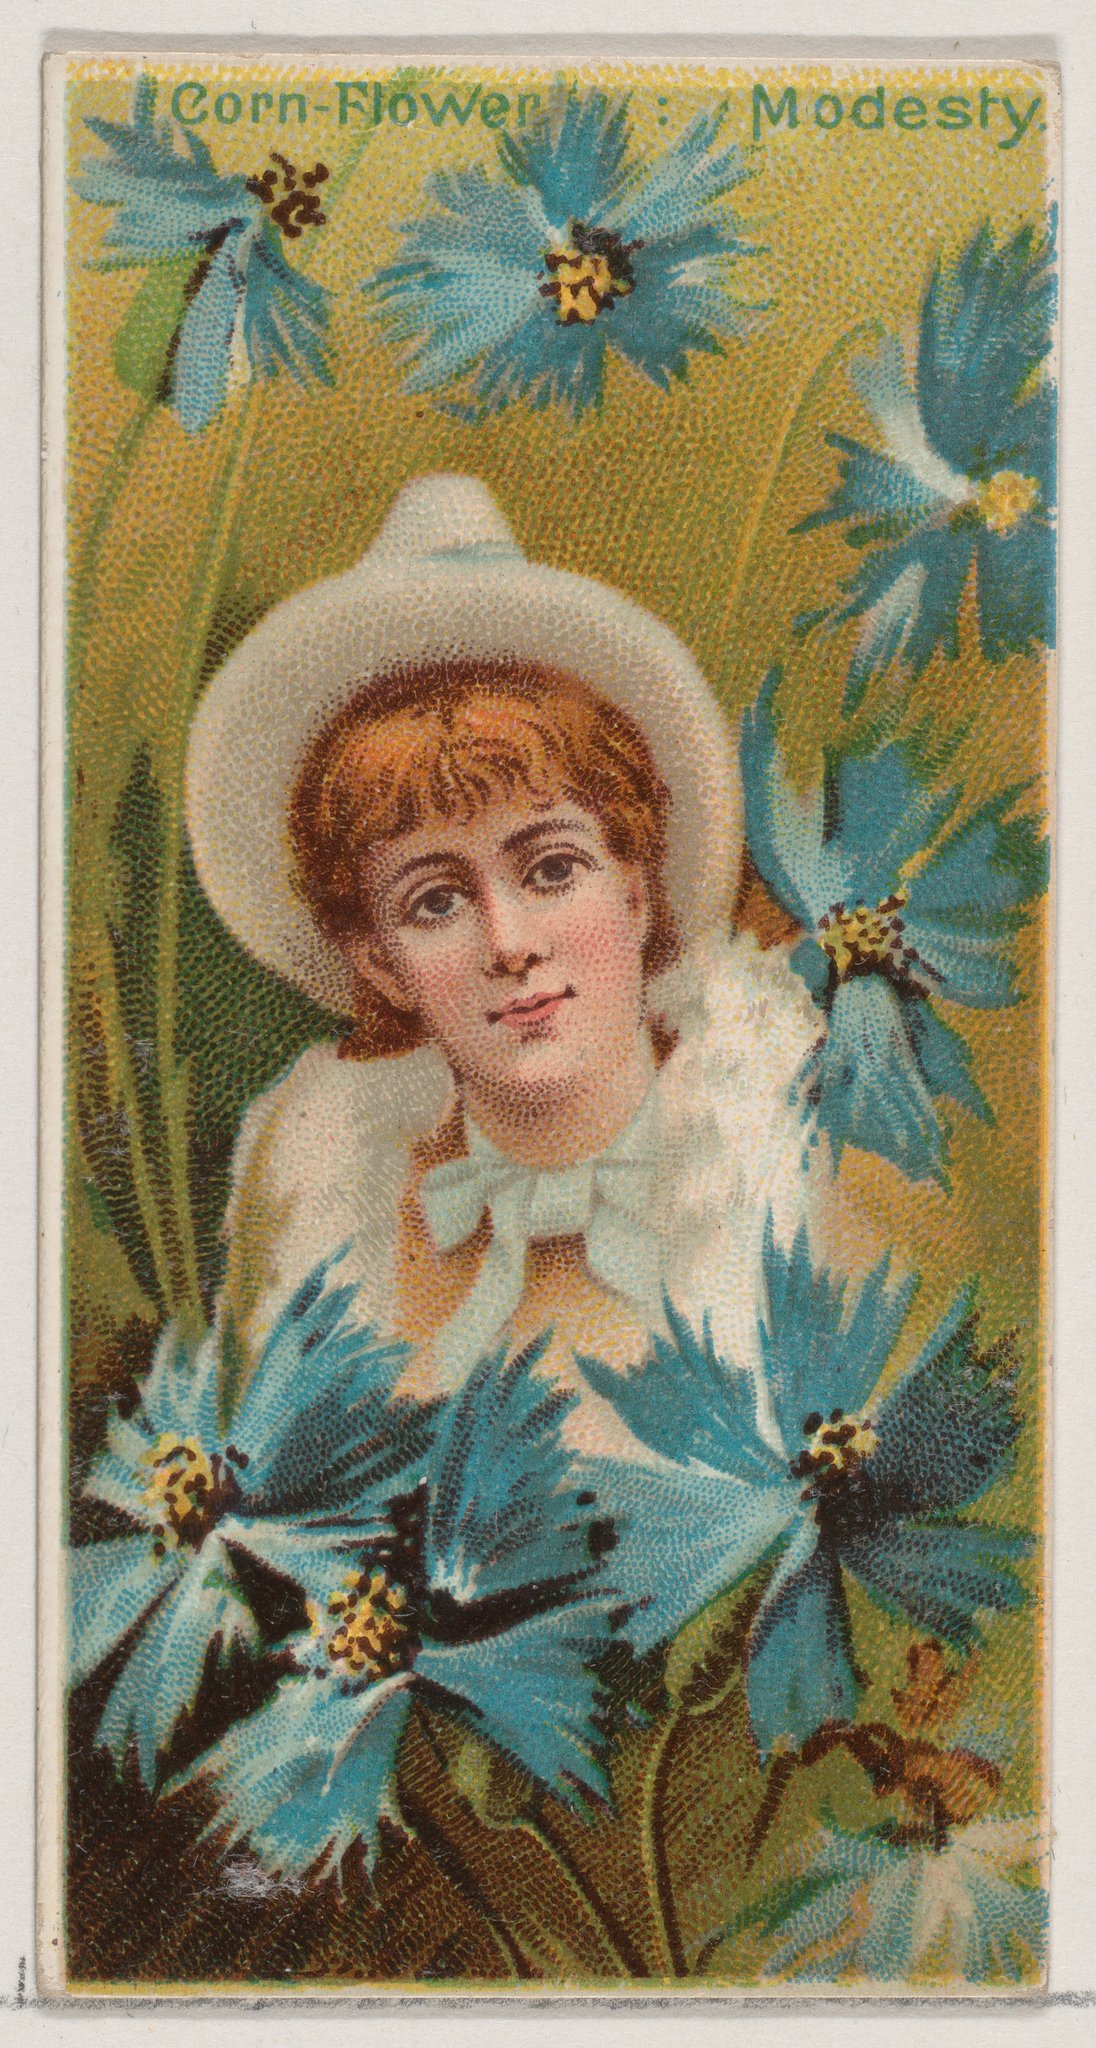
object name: print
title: Cornflower: Modesty, from the series Floral Beauties and Language of Flowers (N75) for Duke brand cigarettes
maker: american tobacco company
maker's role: publisher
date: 1892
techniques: color lithograph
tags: women,flowers